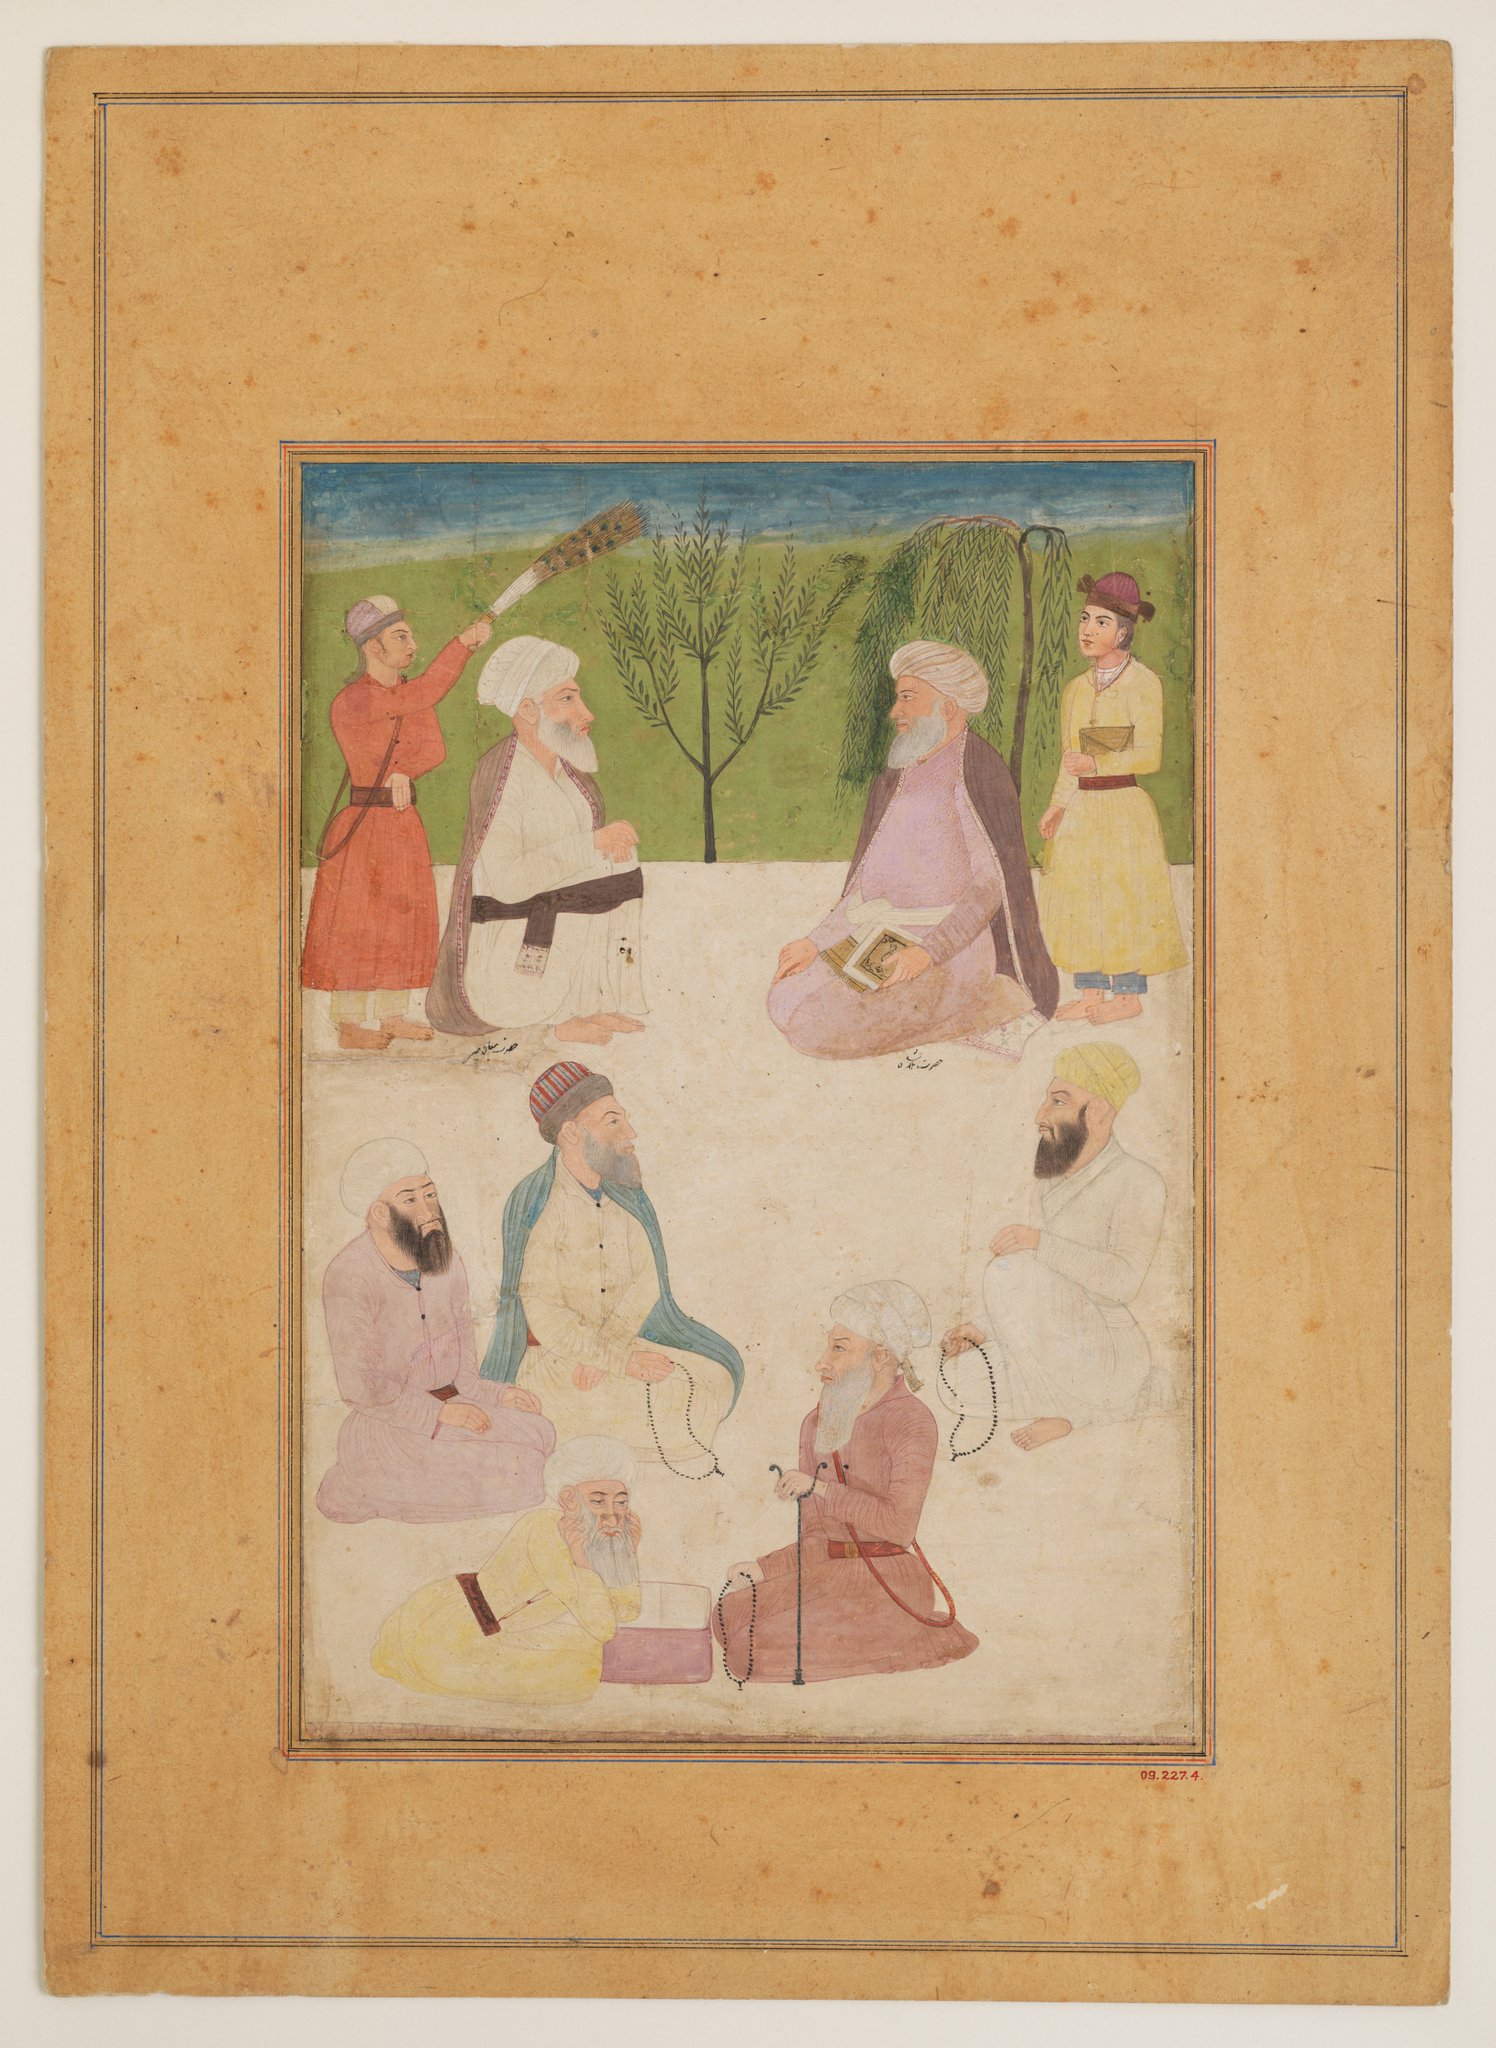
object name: illustrated album leaf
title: Portrait of Mian Mir and Mulla Shah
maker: muhammad musa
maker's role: artist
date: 1695-1705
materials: paper, watercolor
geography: india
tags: men,portraits